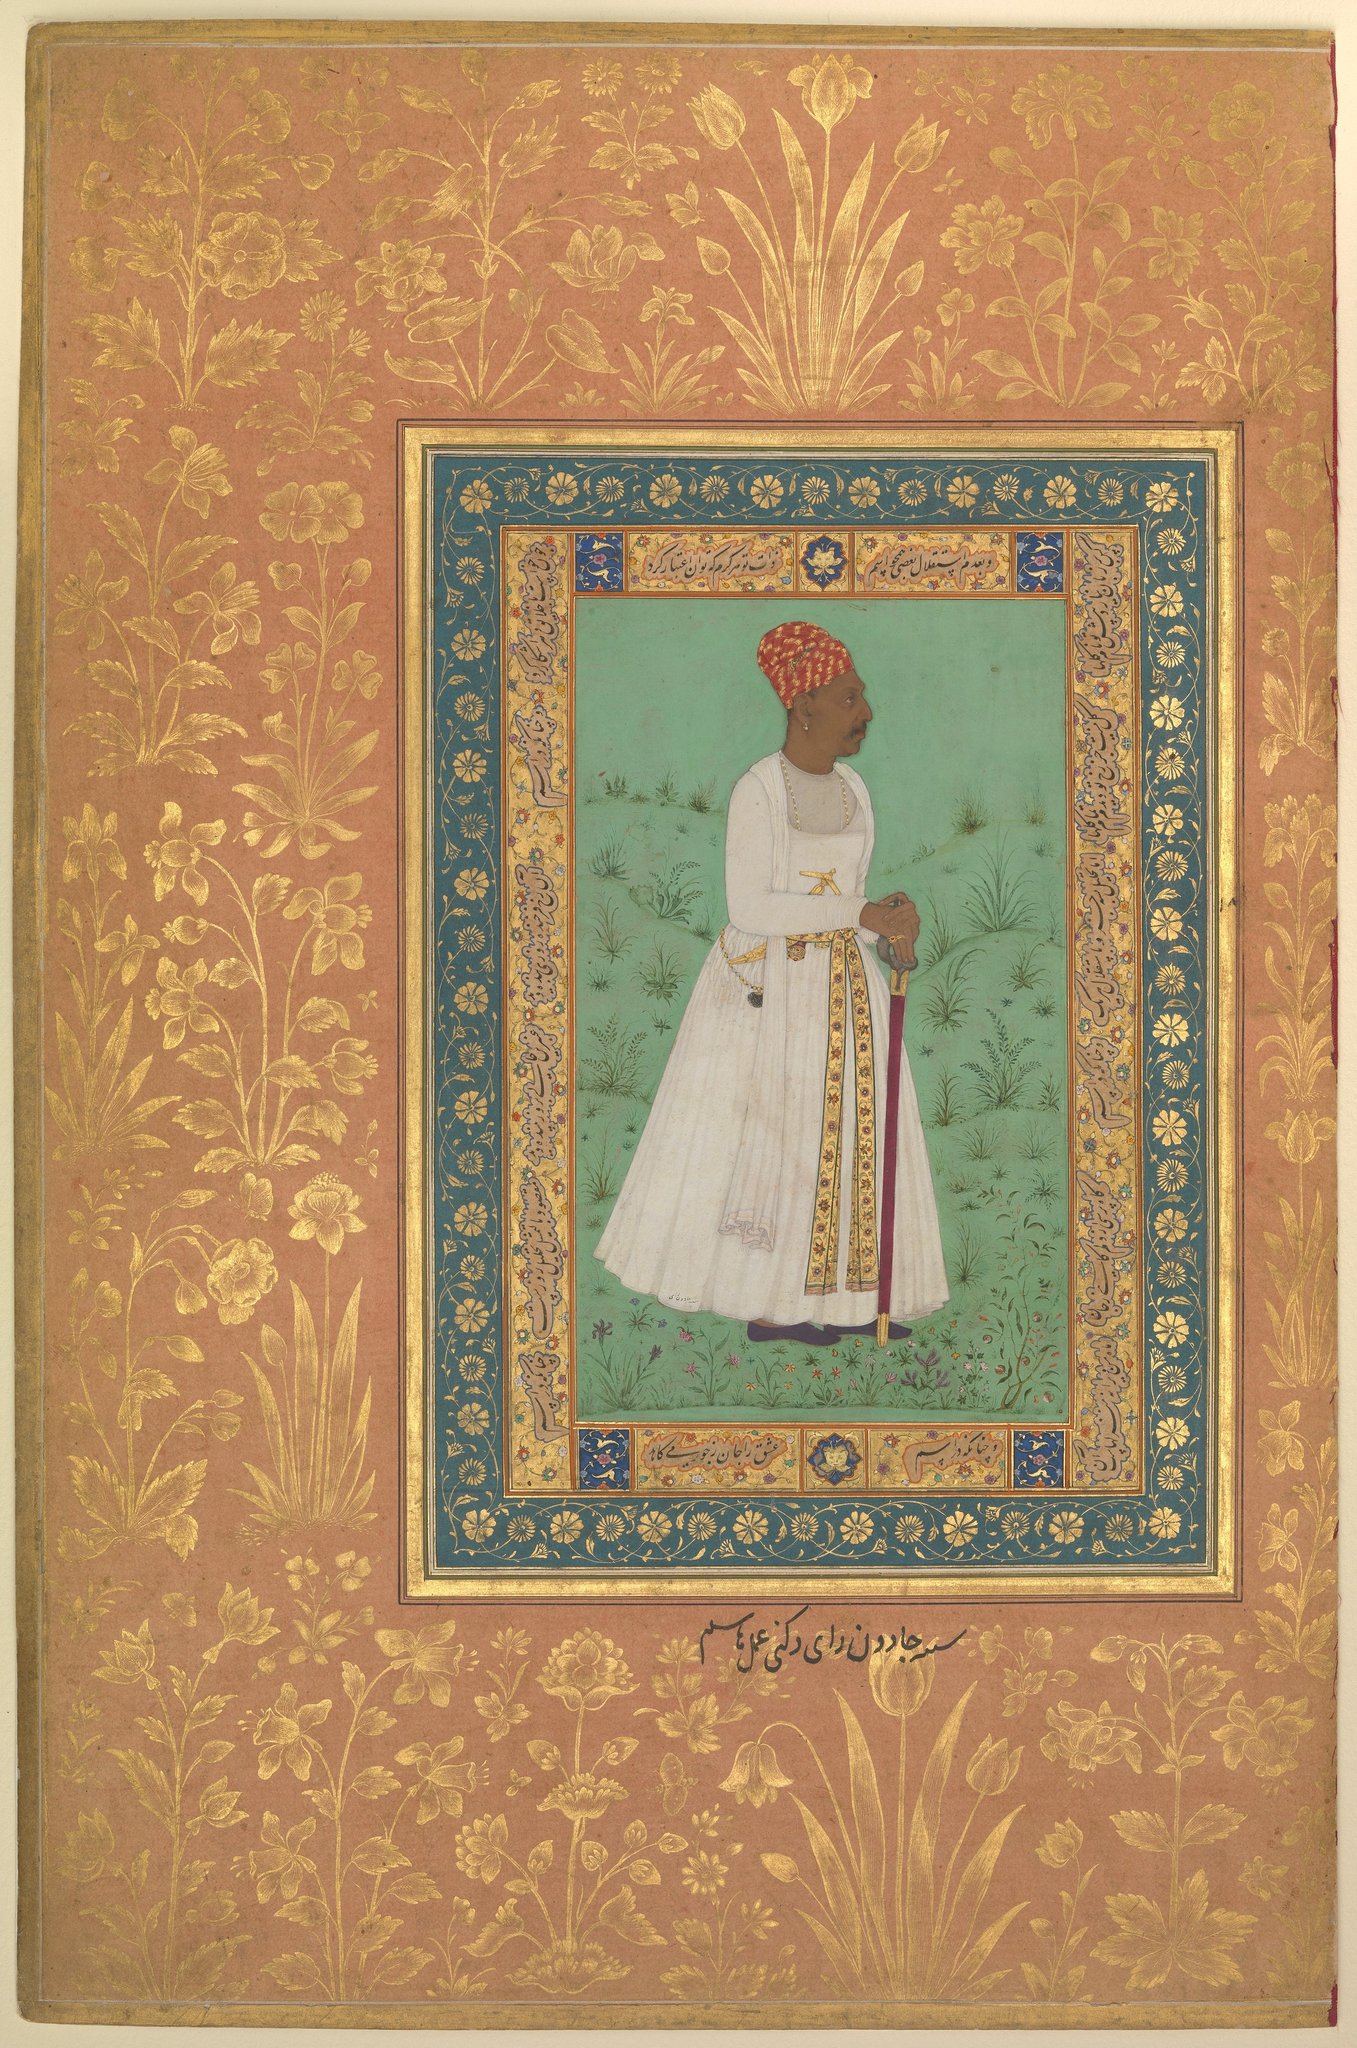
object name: album leaf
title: "Portrait of Jadun Rai Deccani", Folio from the Shah Jahan Album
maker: hashim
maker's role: artist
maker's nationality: indian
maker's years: 1595-1685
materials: gold, ink, paper, watercolor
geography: india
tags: men,portraits